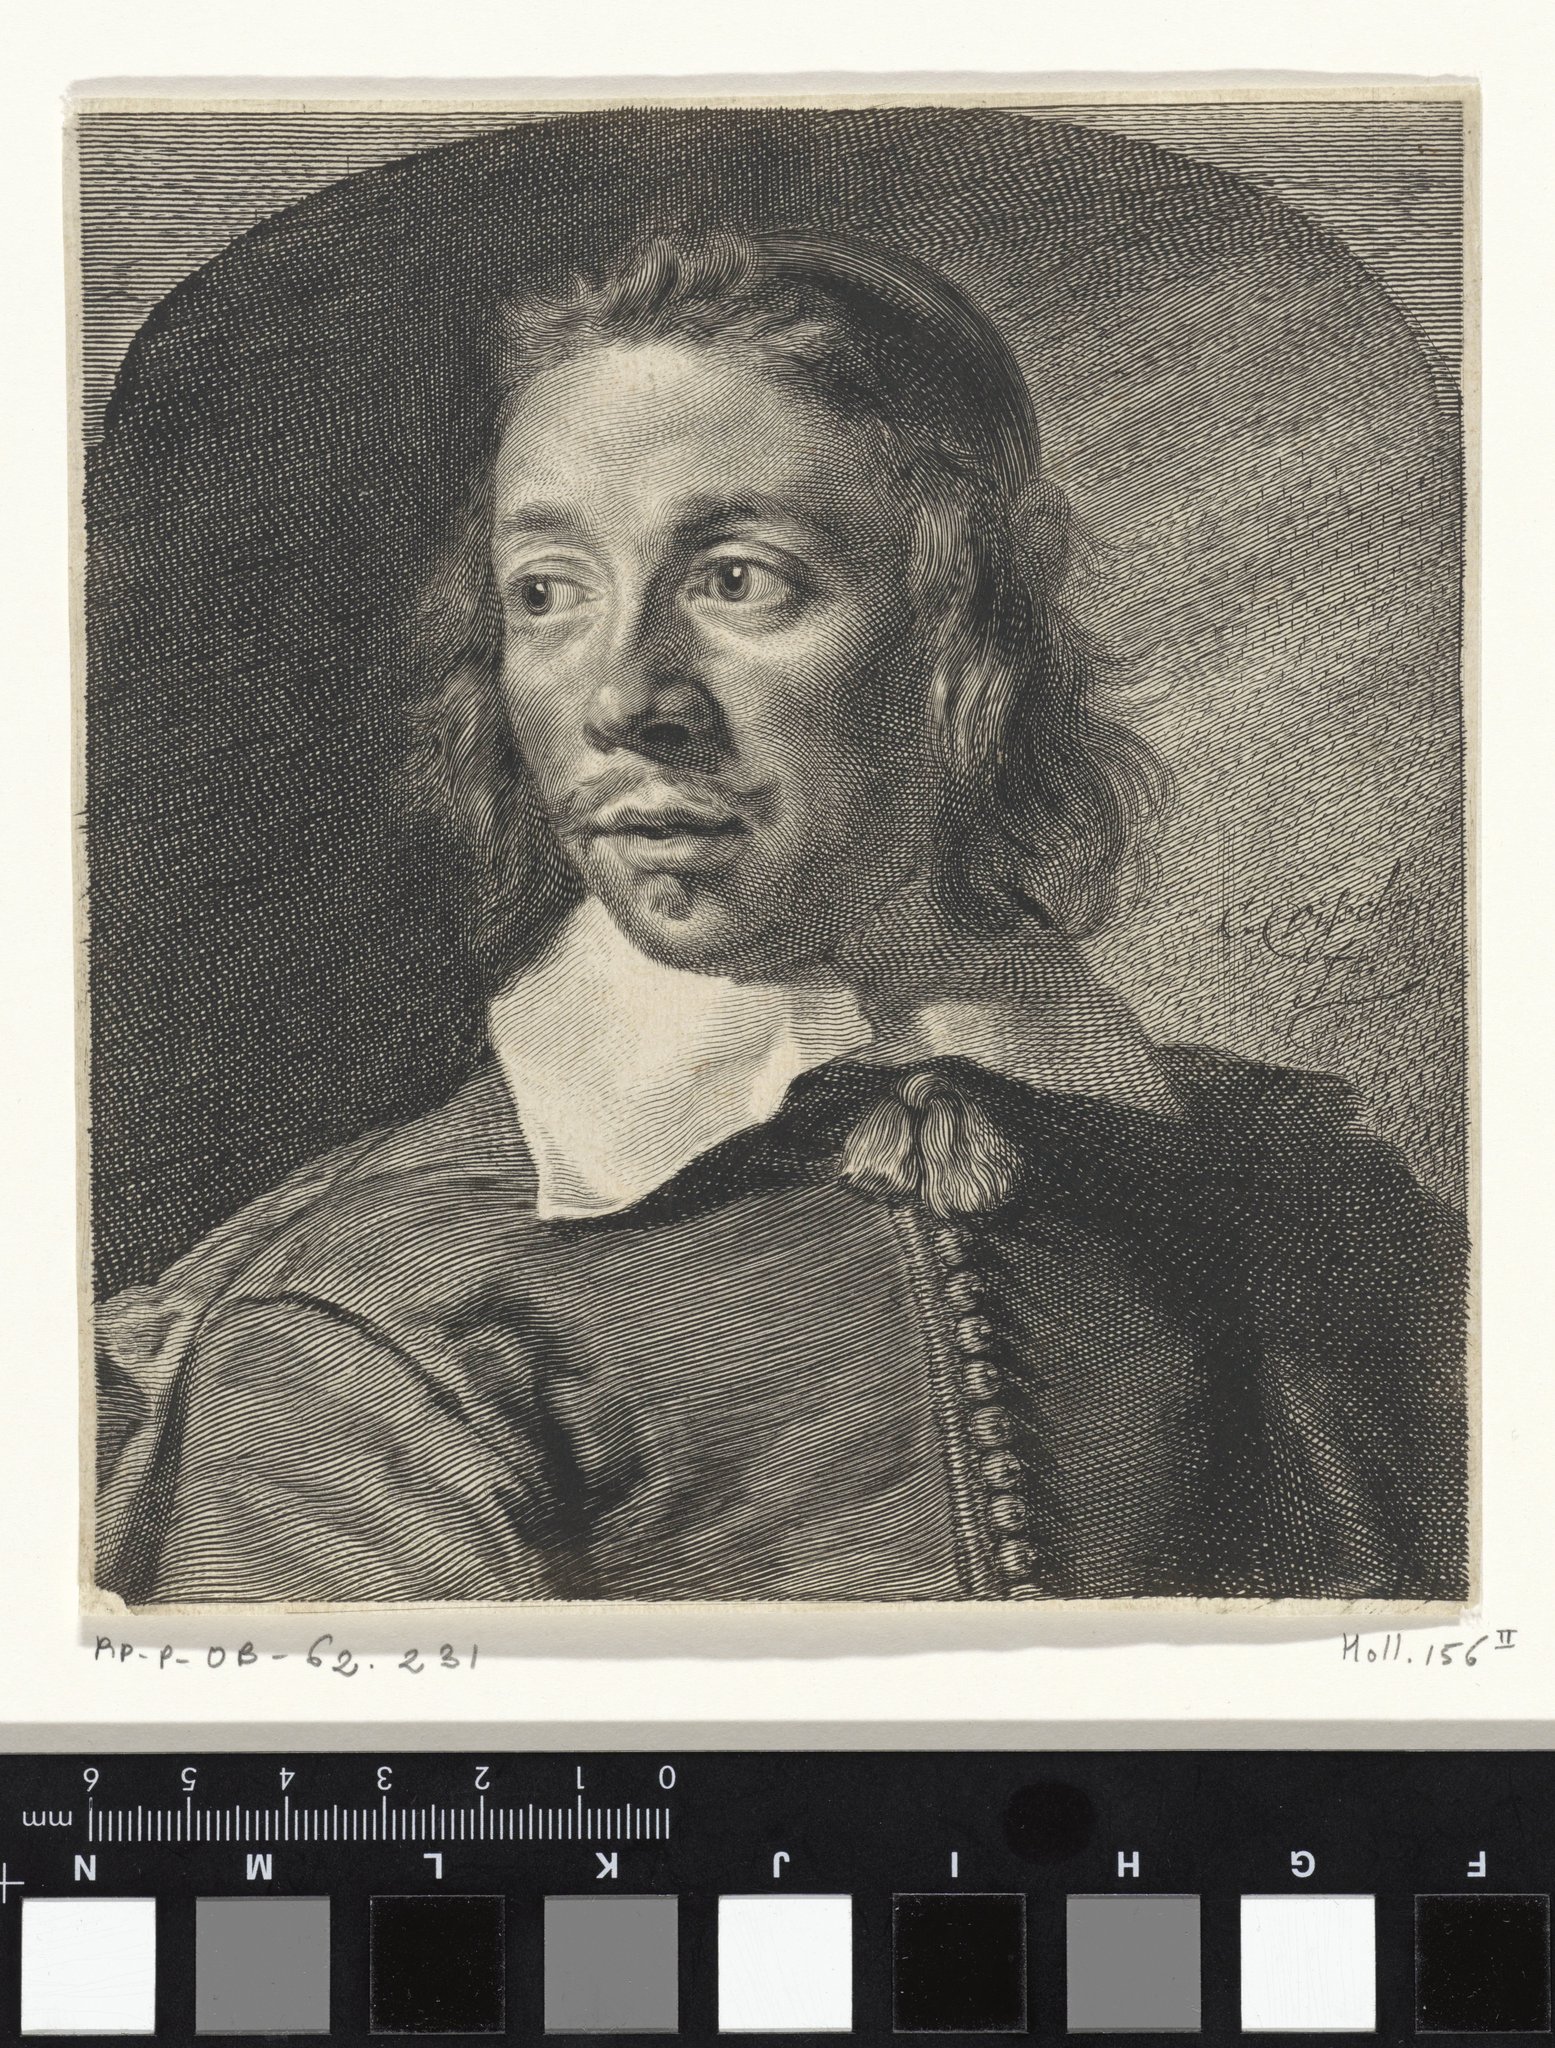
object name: print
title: Portret van Johannes de Paep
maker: cornelis visscher (ii)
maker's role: draughtsman, painter, print maker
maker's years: 1628-1658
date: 1638-1650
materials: paper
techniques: engraving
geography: haarlem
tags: concierge, johannes de paep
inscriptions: collector's mark: Lugt 240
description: Johannes de Paep beursknecht (concierge) van de Beurs van Hendrick de Keyser te Amsterdam van 1643 tot 1650.